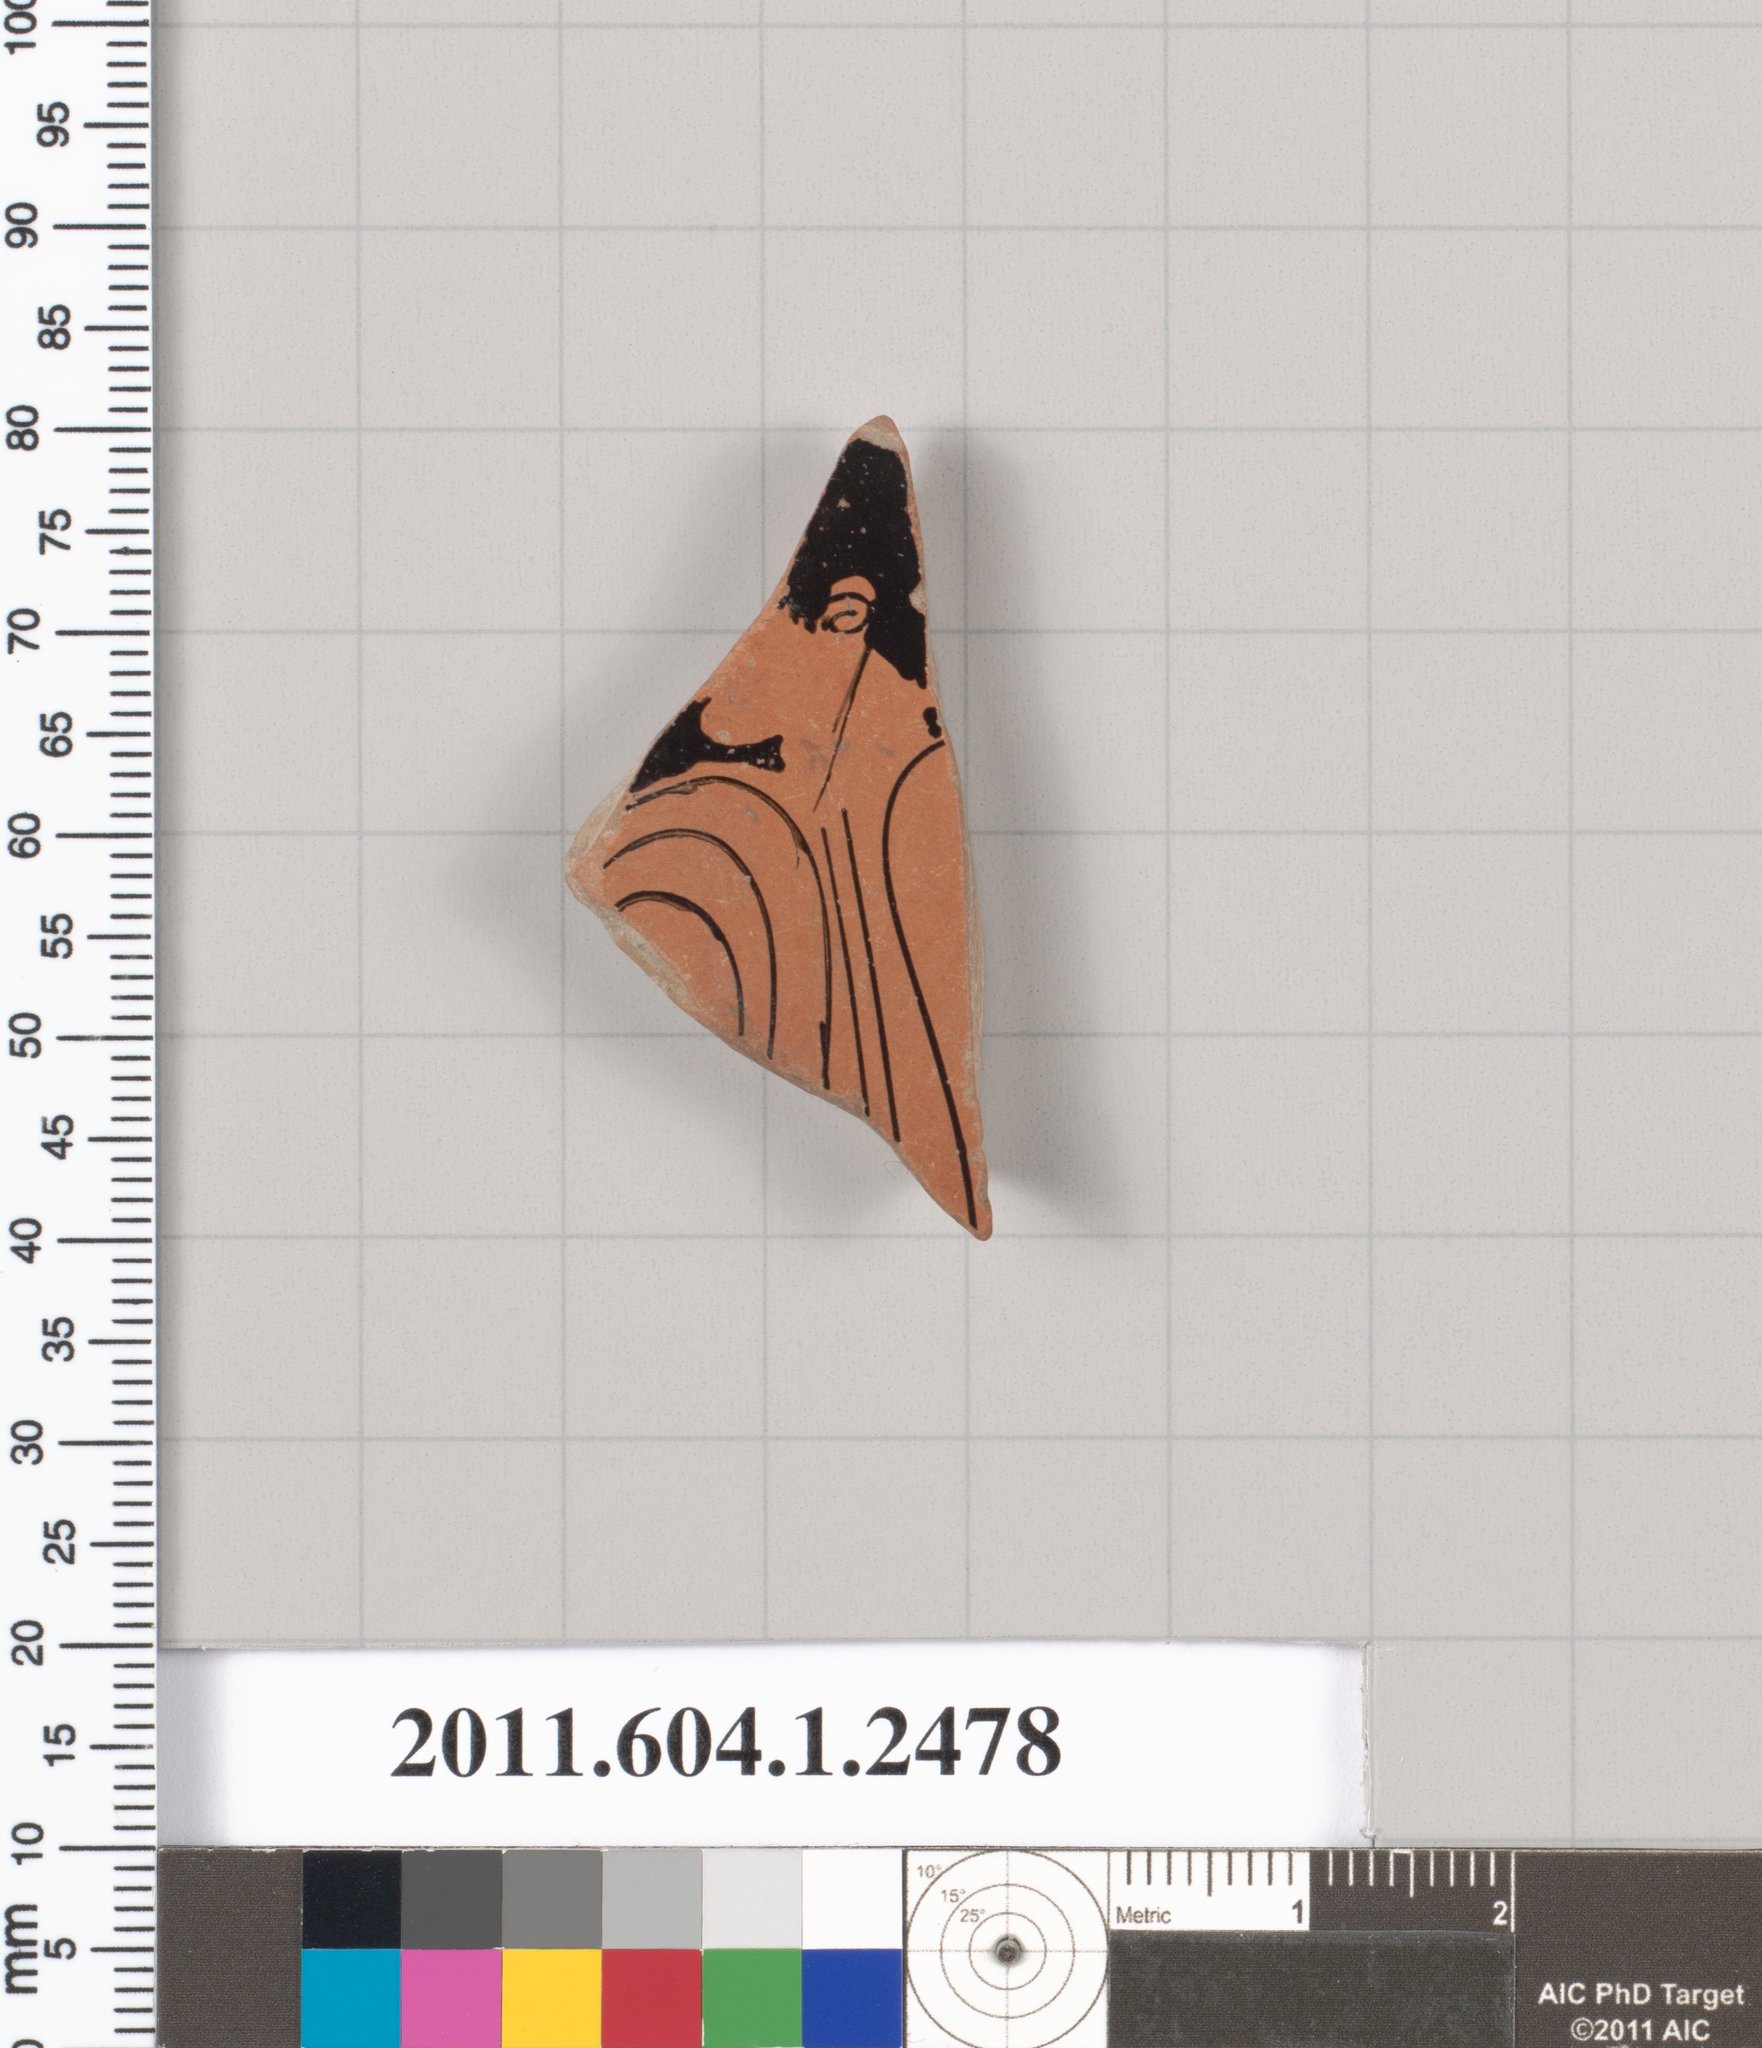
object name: kylix fragment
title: Terracotta fragment of a kylix (drinking cup)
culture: greek, attic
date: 500-476 BCE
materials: terracotta